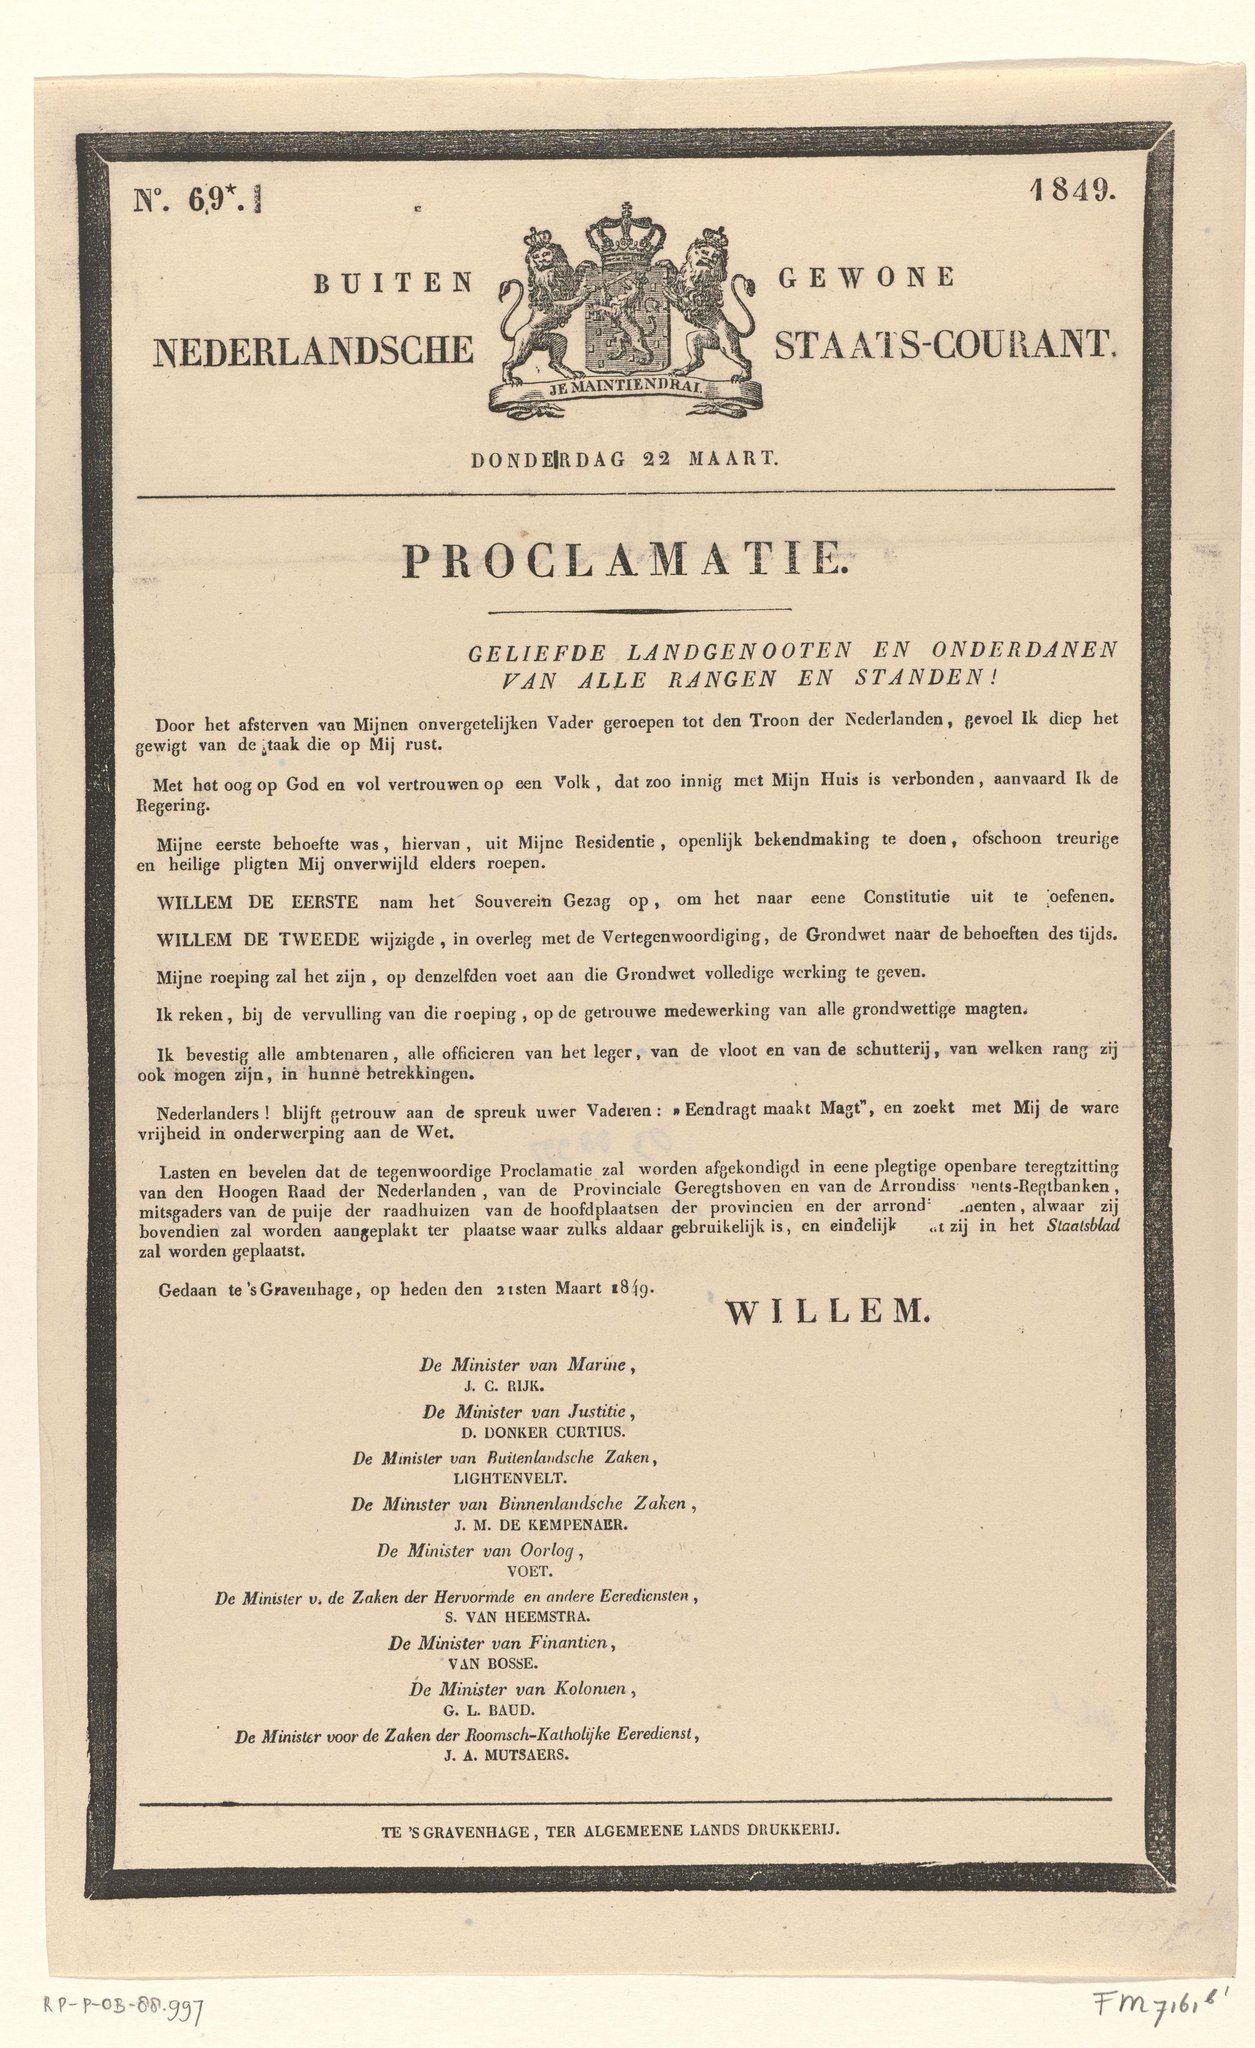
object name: newspaper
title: Nederlandsche Staats-Courant. Donderdag 22 Maart. No. 69*. 1849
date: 1849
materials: paper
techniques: letterpress printing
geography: the hague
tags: brussels, willem iii (koning der nederlanden)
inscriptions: collector's mark: Lugt 2228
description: Exemplaar van de Nederlandse Staatscourant van 22 maart 1849, met de proclamatie van koning Willem III. Blad met zwarte rouwranden bedrukt op één zijde. Bovenaan een vignet met het rijkswapen.